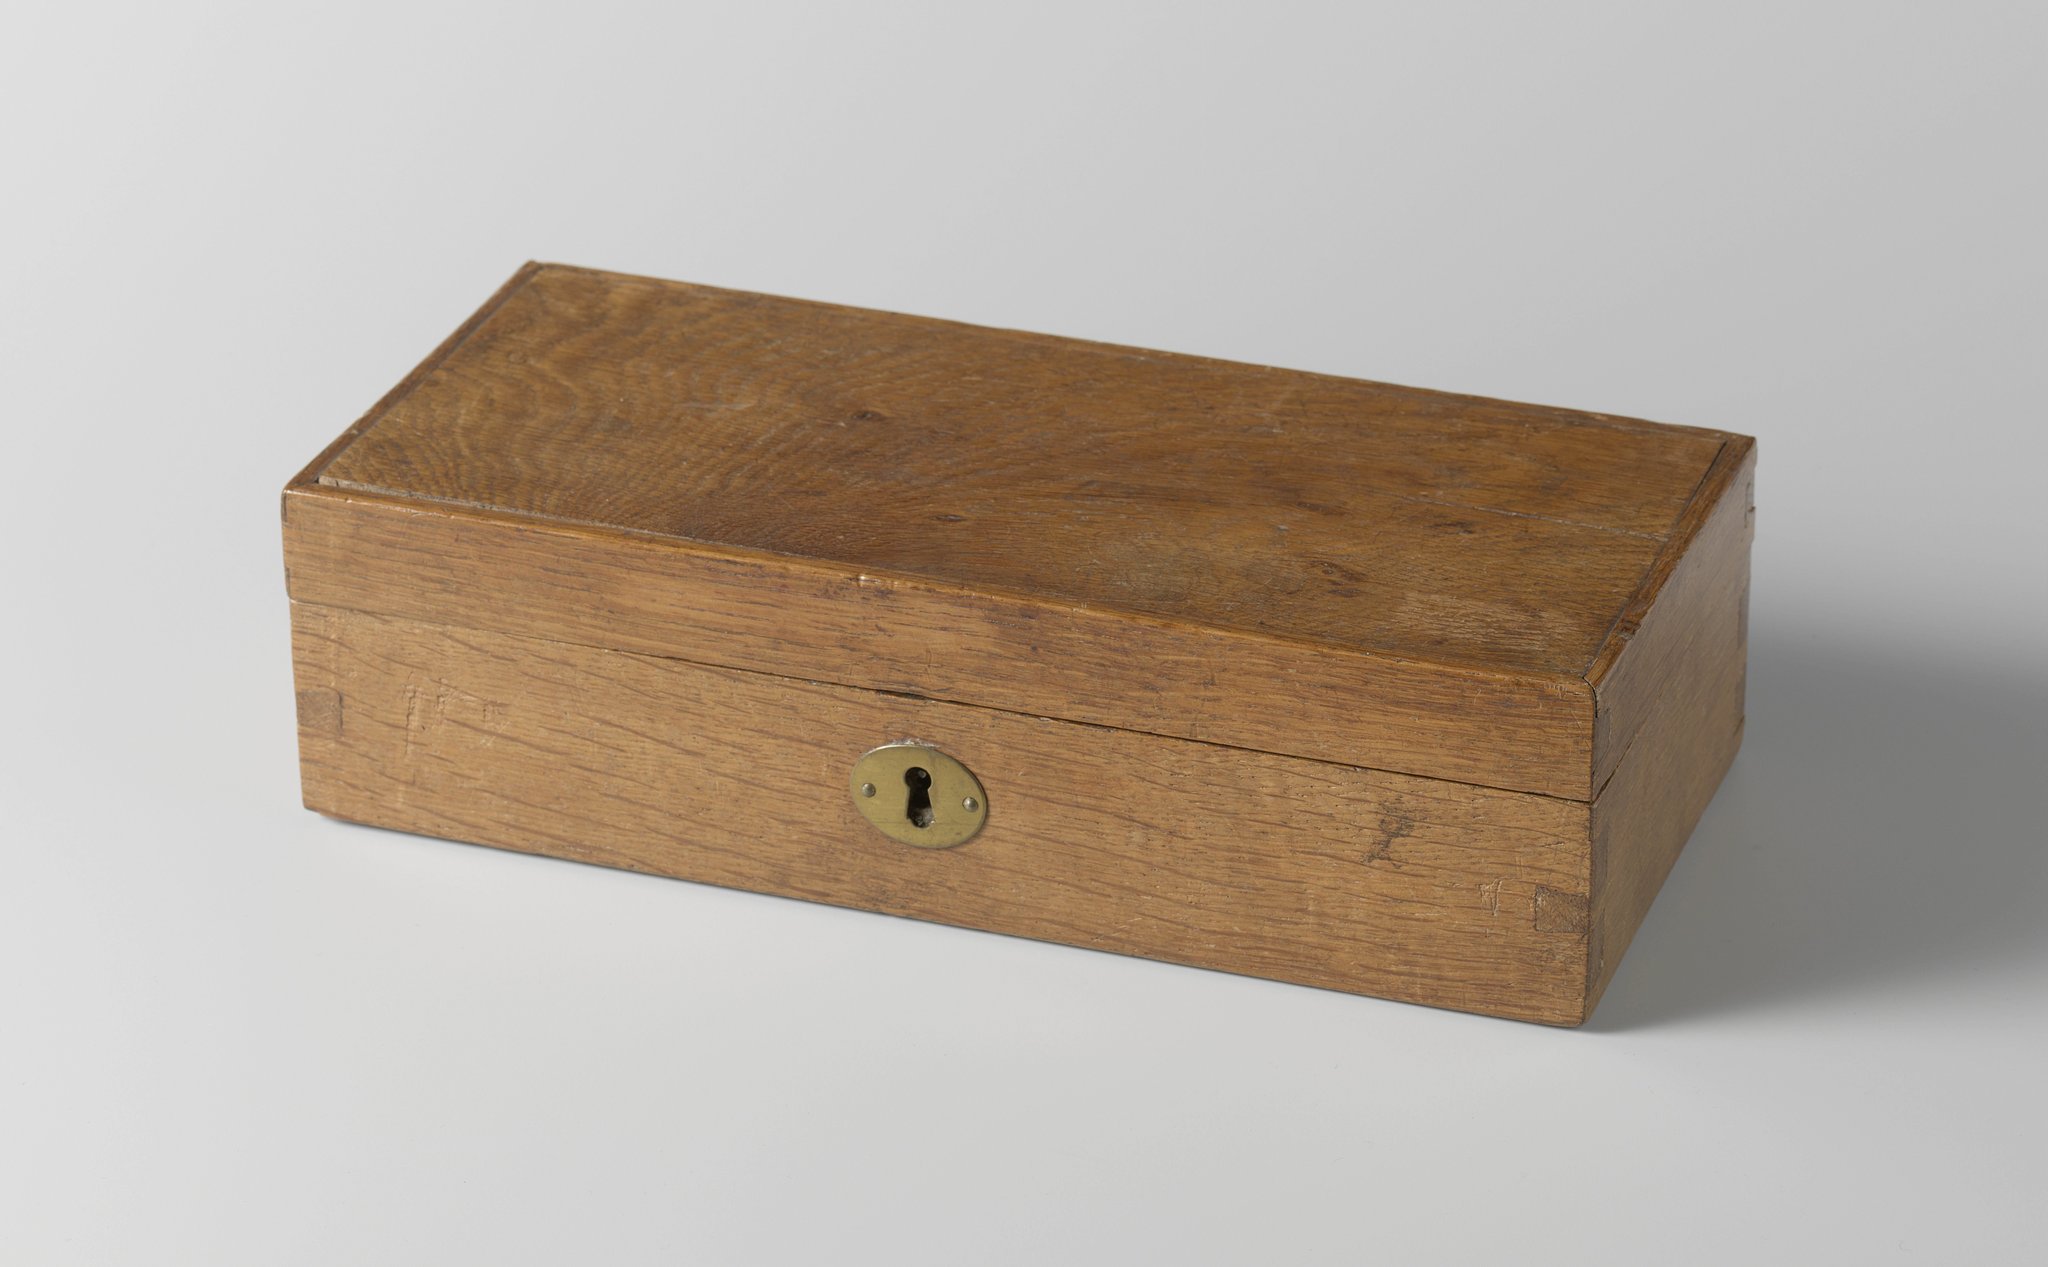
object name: chest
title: Small chest made of wood from Jan van Speijk’s gunboat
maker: j. h. cuperus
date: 1831-1832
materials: copper, paper, textile, wood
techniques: woodworking, forging, printing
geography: antwerp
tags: amsterdam, antwerp, jan van speyk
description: According to an accompanying certificate, this chest originally contained ‘remains of Van Speijk’. Like the adjacent snuffbox, it is reputedly made of fragments of wood from the gunboat, while the rings and the nutcracker are of iron recovered from the vessel. Many objects of this kind were awarded as prizes in a national lottery whose proceeds financed the construction of the Van Speijk lighthouse at Egmond aan Zee.